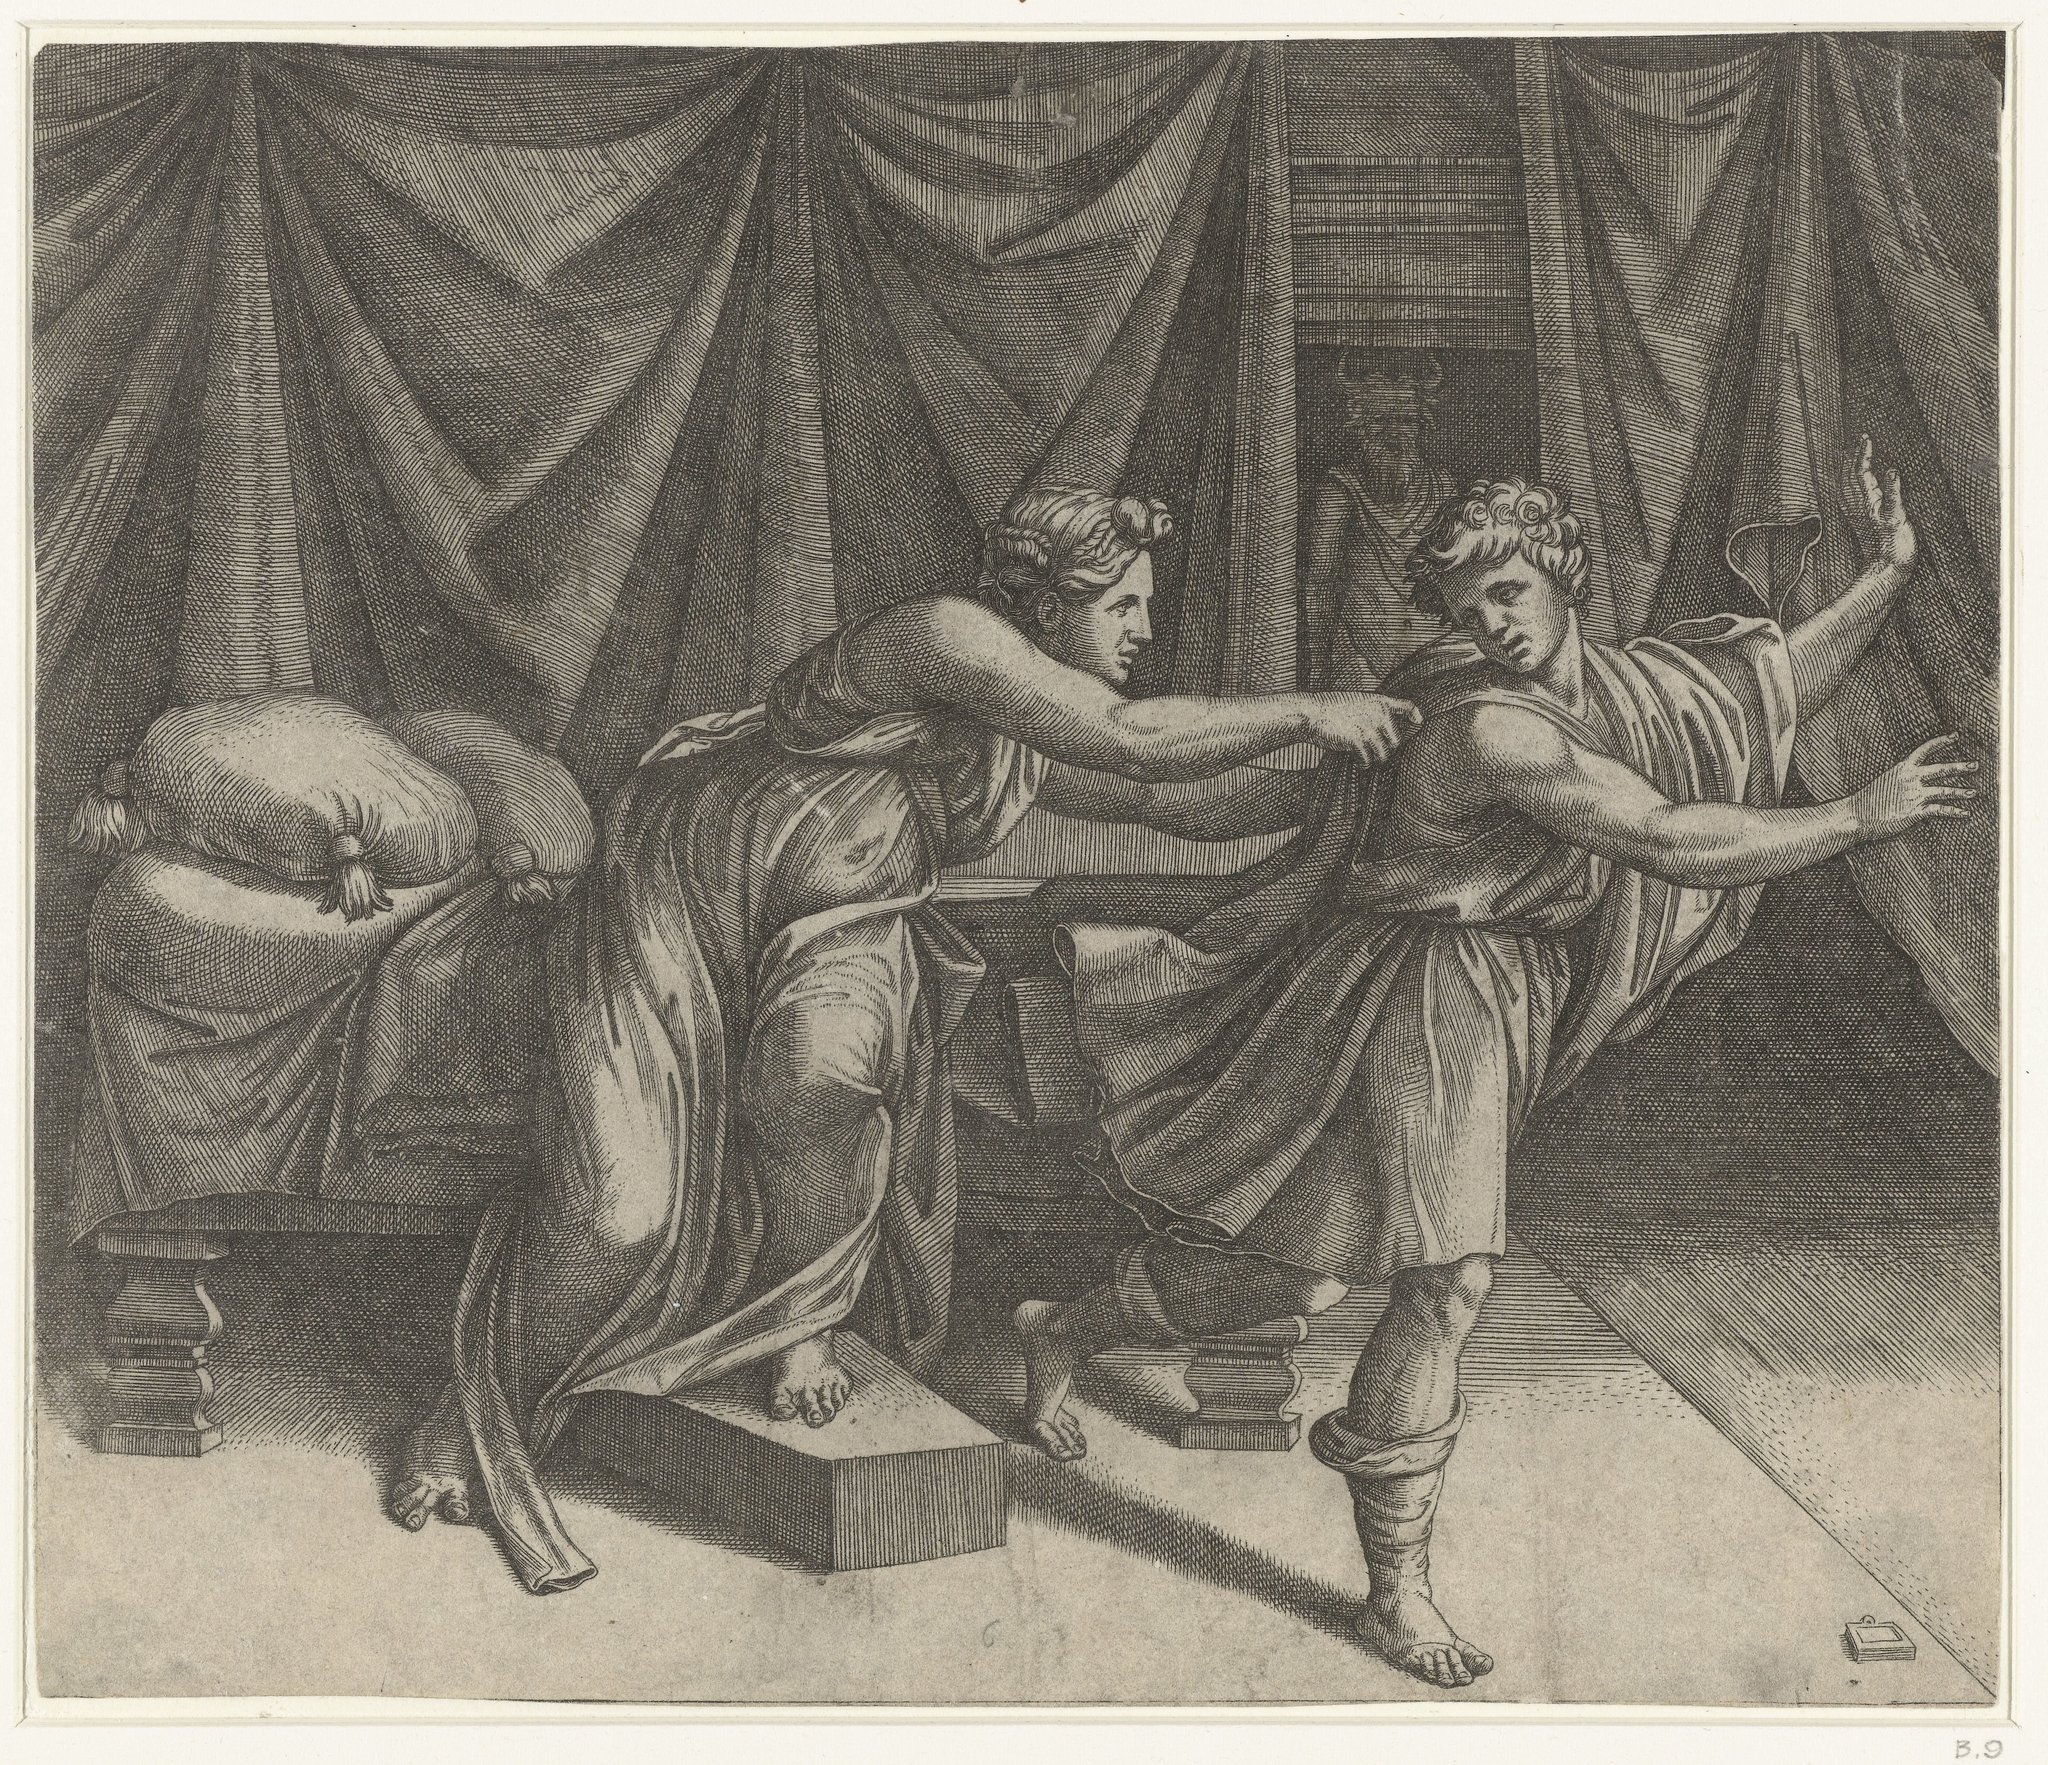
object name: print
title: Jozef en de vrouw van Potifar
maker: marcantonio raimondi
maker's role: print maker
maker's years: 1470-1534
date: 1515-1525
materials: paper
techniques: engraving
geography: italy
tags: potiphar's wife catches joseph by his robe, usually while lying in bed; joseph escapes leaving his cloak behind in her hands (possibly with a naked child lying in a crib)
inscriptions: collector's mark: Lugt 240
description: Prent naar ontwerp van Raphael voor fresco in Vaticaan te Rome.